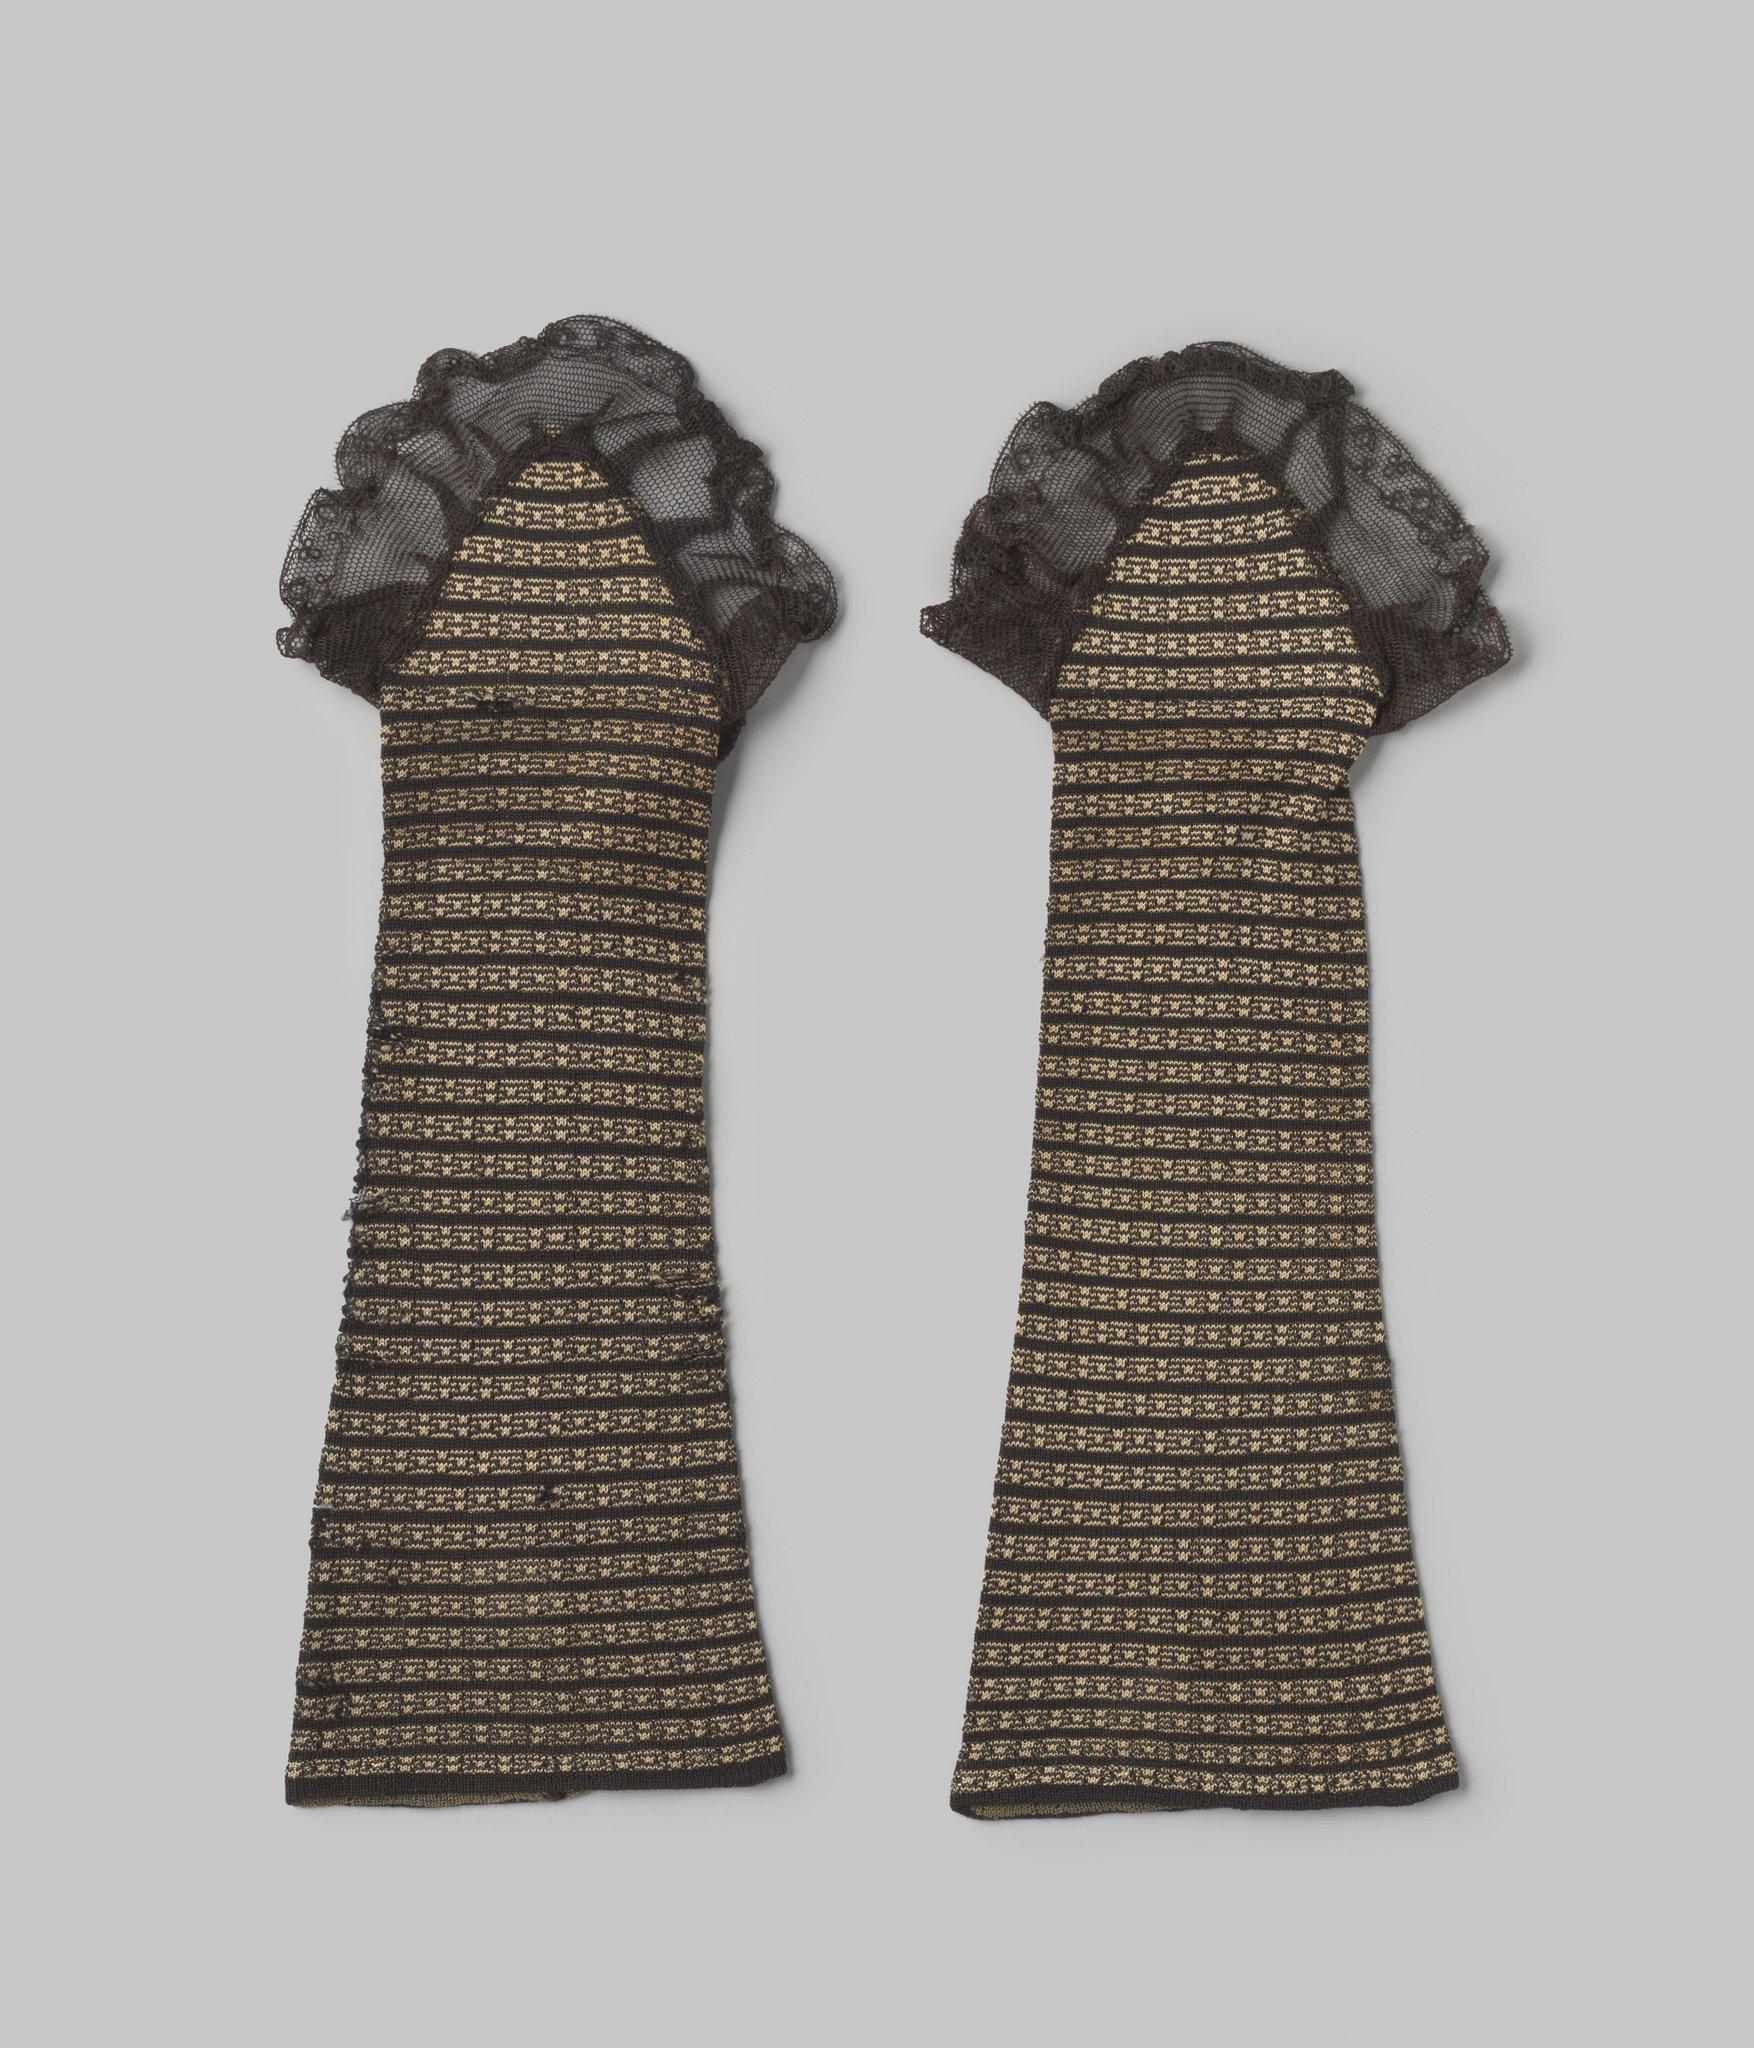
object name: clothing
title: Mitaine van zijde, wit en zwart gestreept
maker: Anonymous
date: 1750-1800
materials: silk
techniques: knitting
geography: zaanstreek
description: Mitaine van zijde, wit en zwart gestreept. In de witte banen met een zwart omlijnd geometrisch patroon. Afgezet met zwarte doorstop tule.